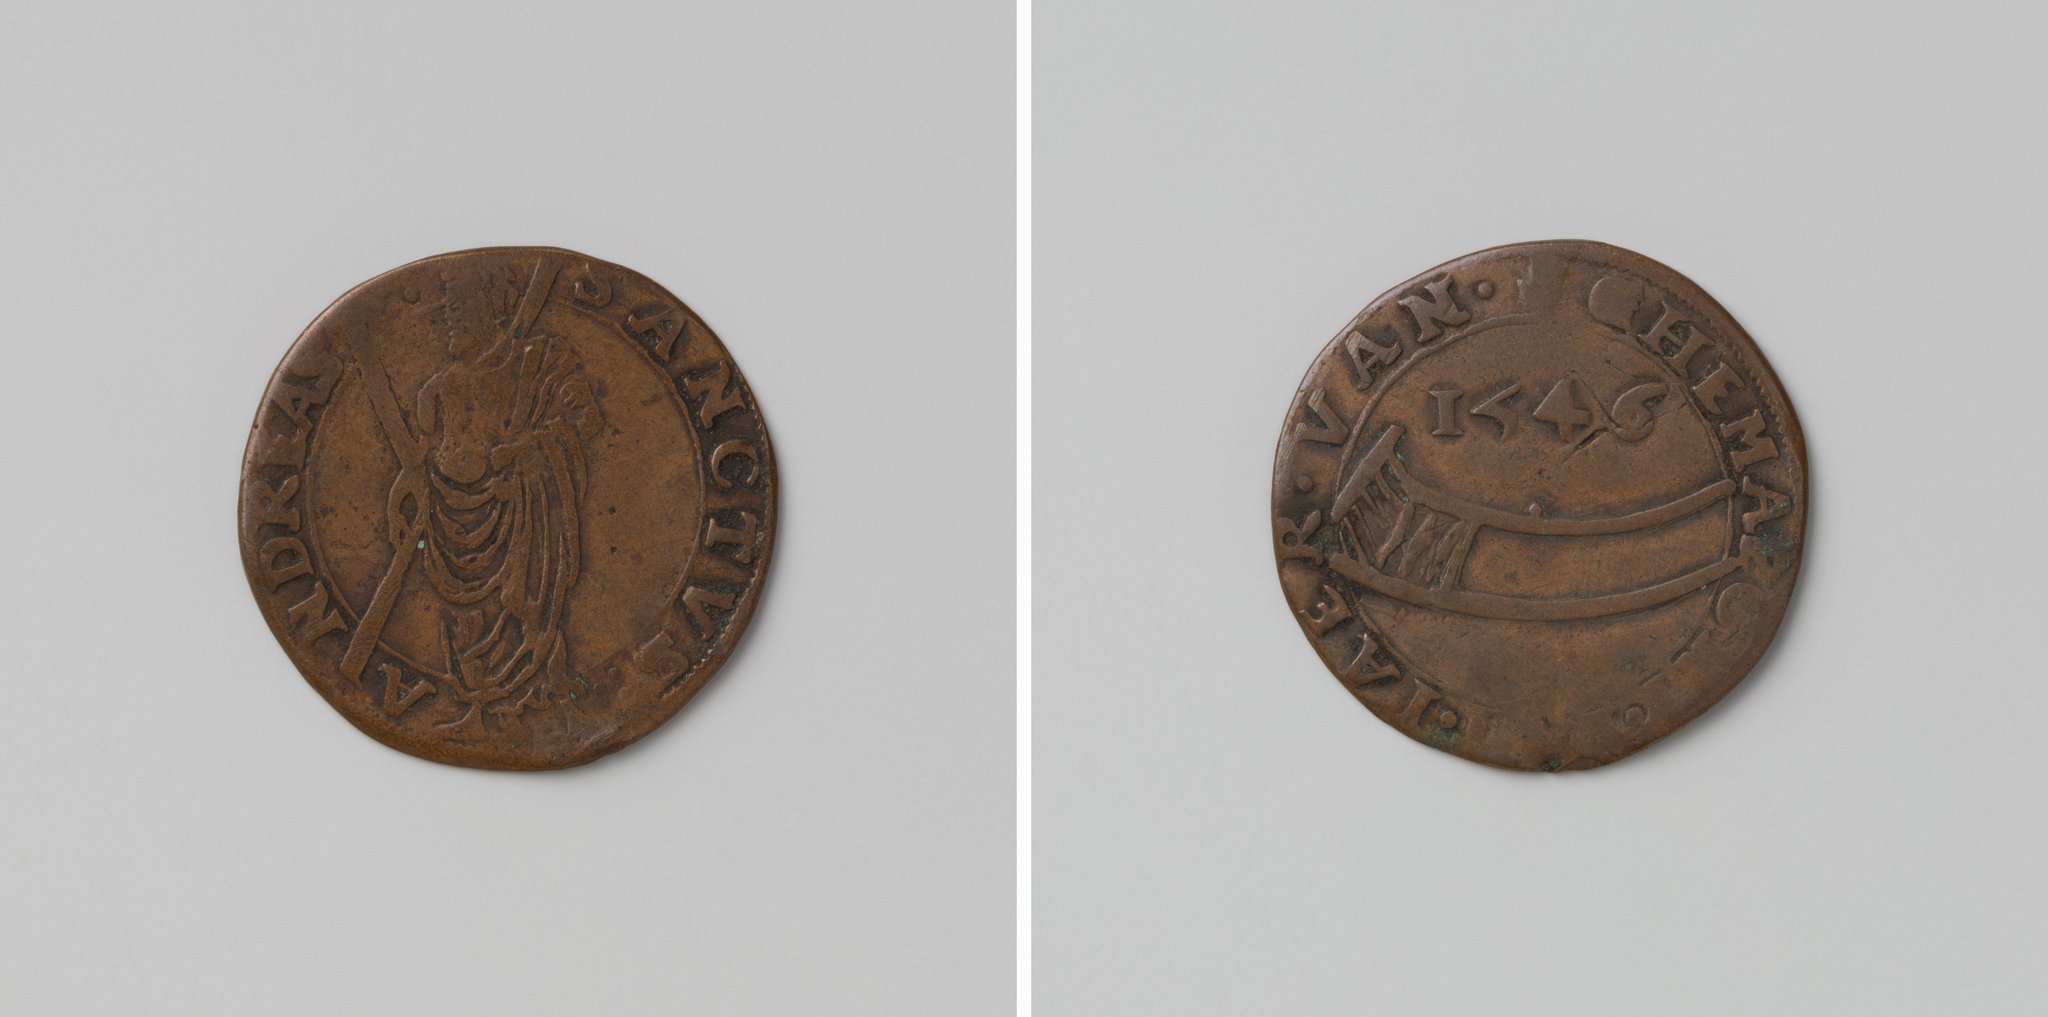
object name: medal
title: Sint Andreas- of kruiersgilde van Antwerpen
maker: Anonymous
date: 1546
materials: copper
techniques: striking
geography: antwerp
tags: antwerp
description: Koperen penning. Voorzijde: Andreas met kruis binnen omschrift. Keerzijde: sleep onder jaartal binnen omschrift